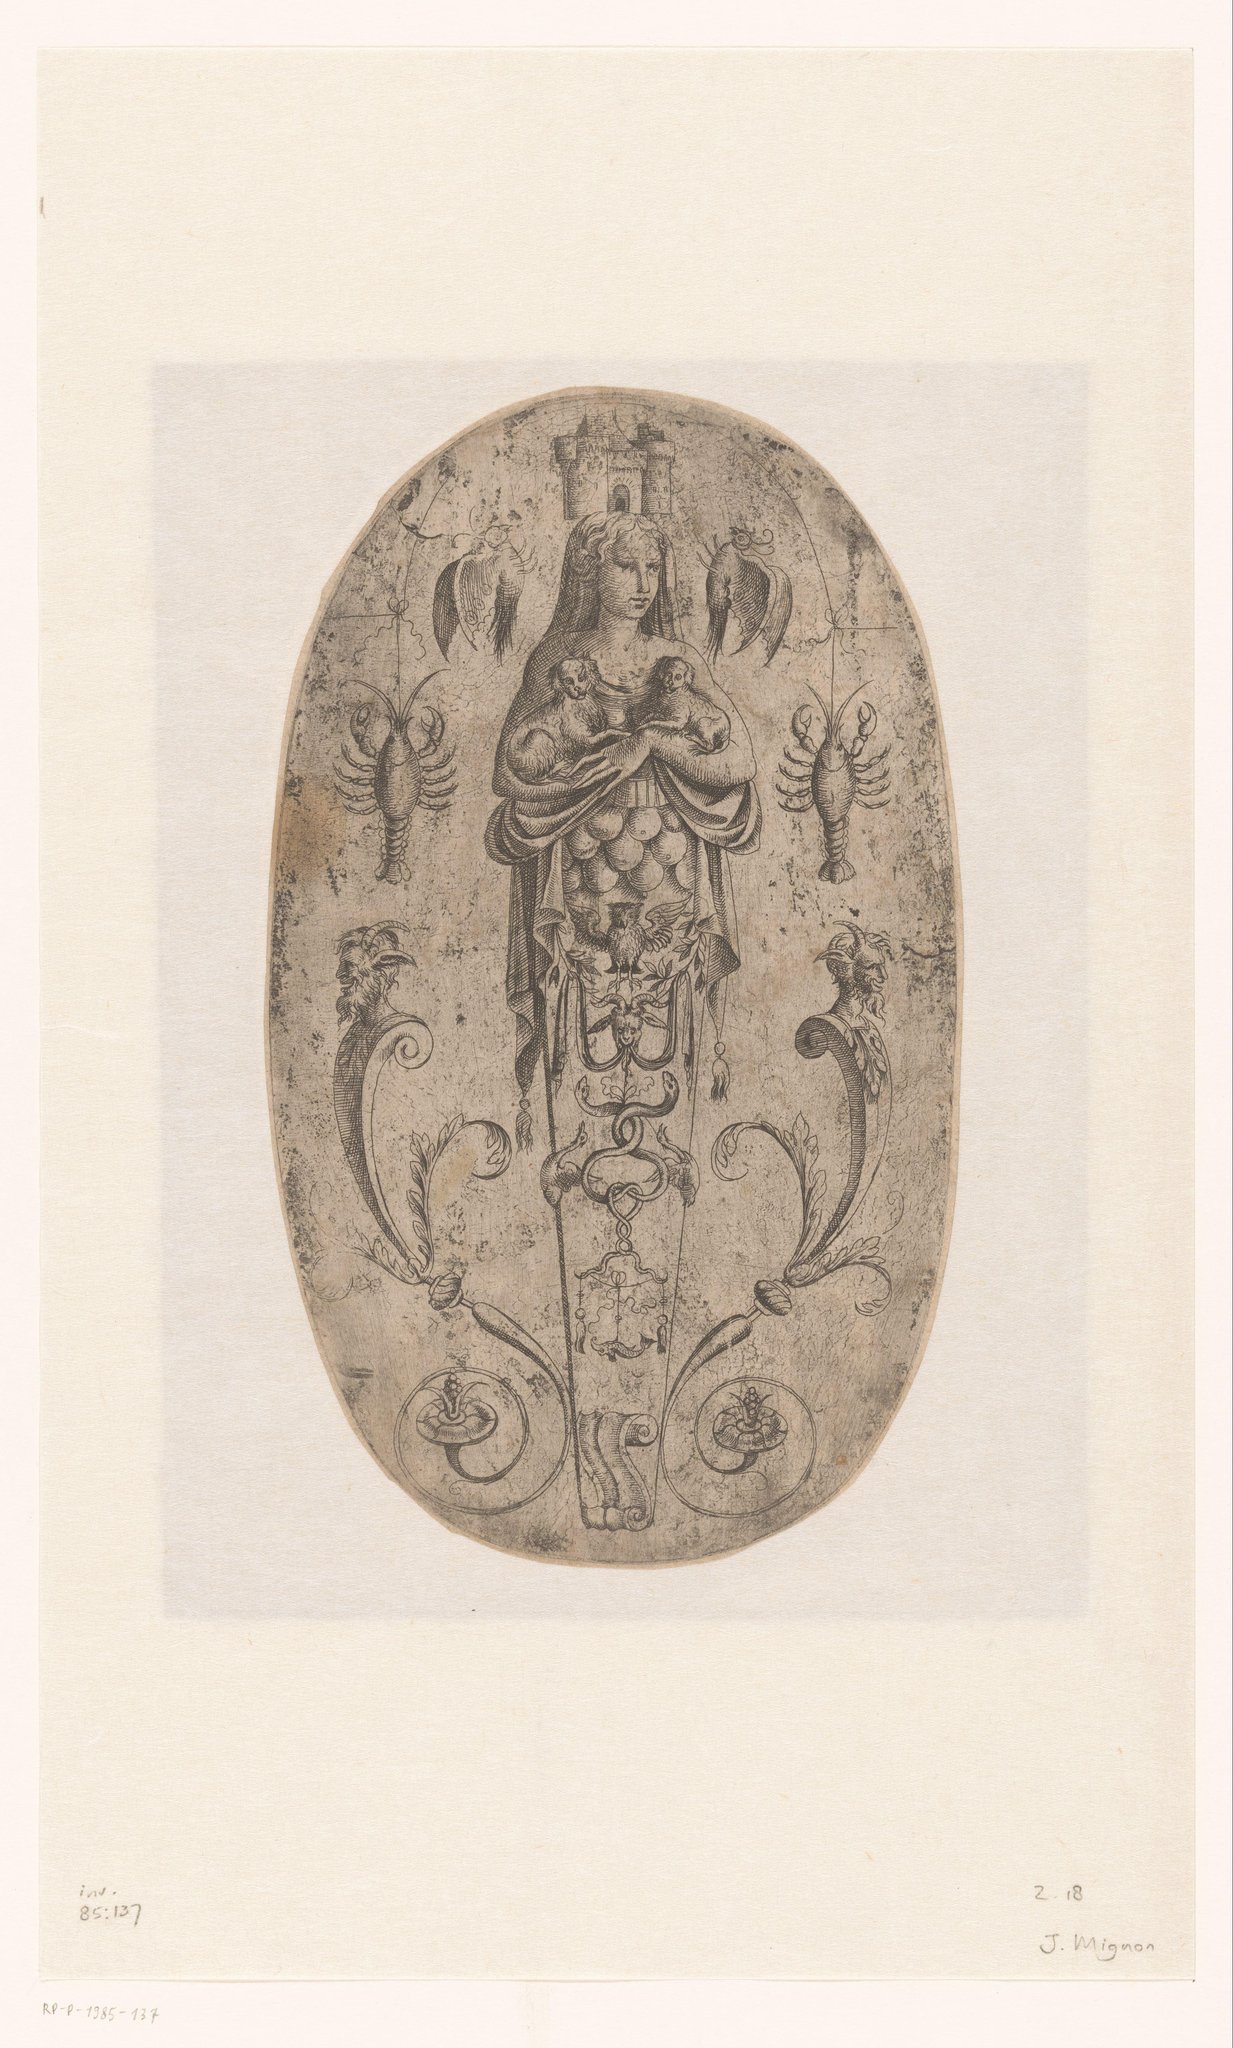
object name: print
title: Twintig hermen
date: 1543-1545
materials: paper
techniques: etching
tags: (story of) diana (artemis)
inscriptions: collector's mark: Lugt 2760, collector's mark: Lugt 2228